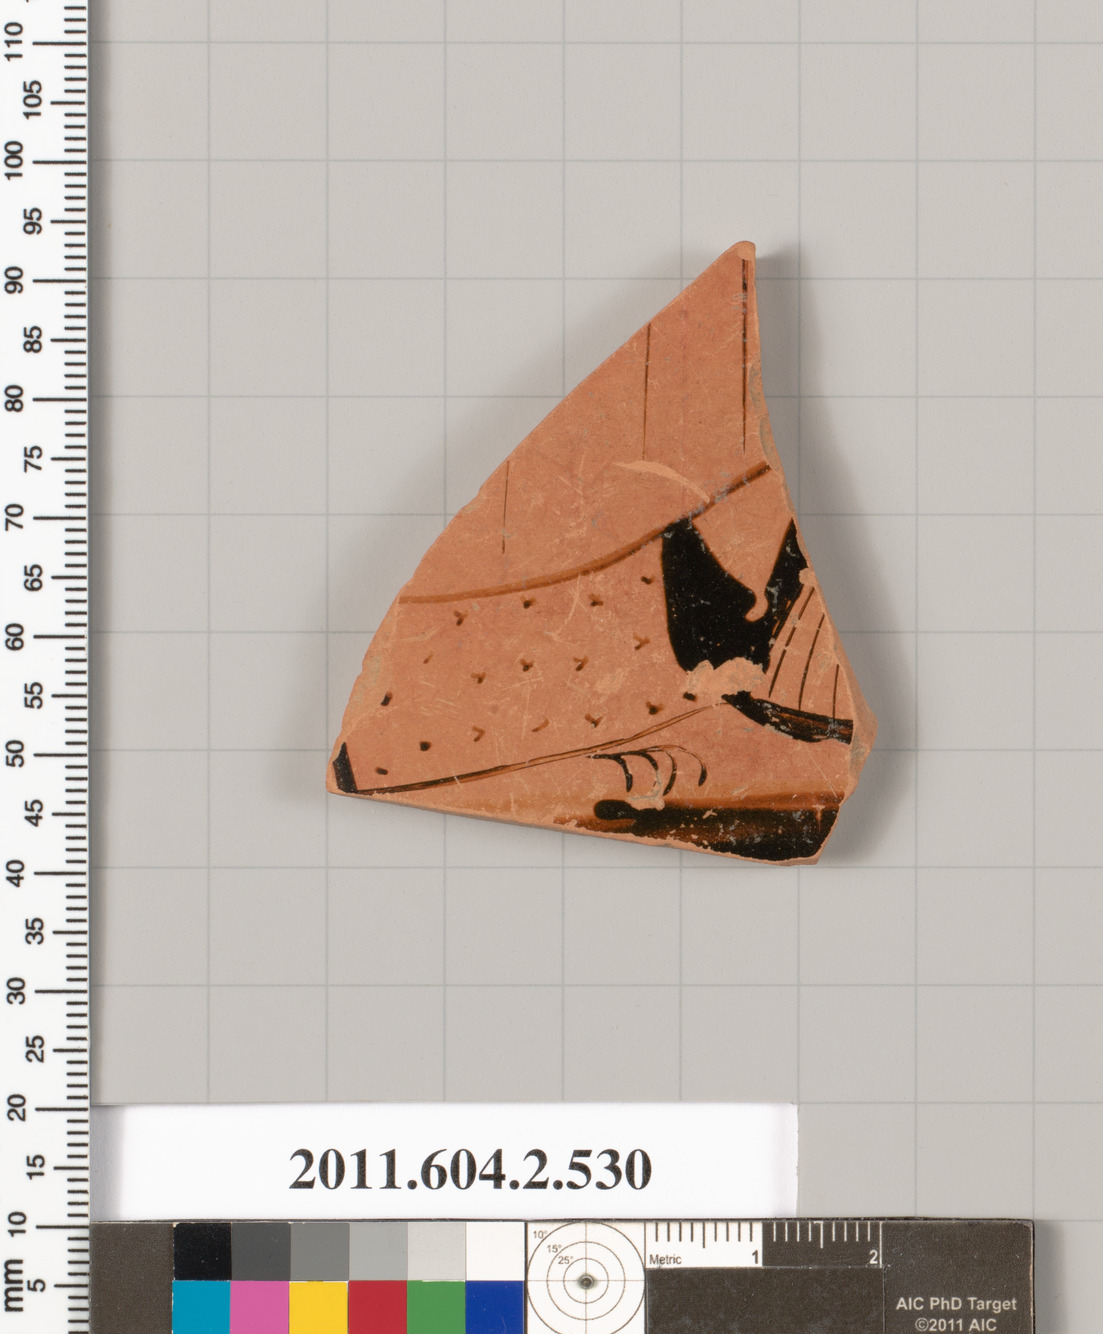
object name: column krater fragment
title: Terracotta fragment of a column-krater (bowl for mixing wine and water)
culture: greek, attic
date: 440-420 BCE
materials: terracotta